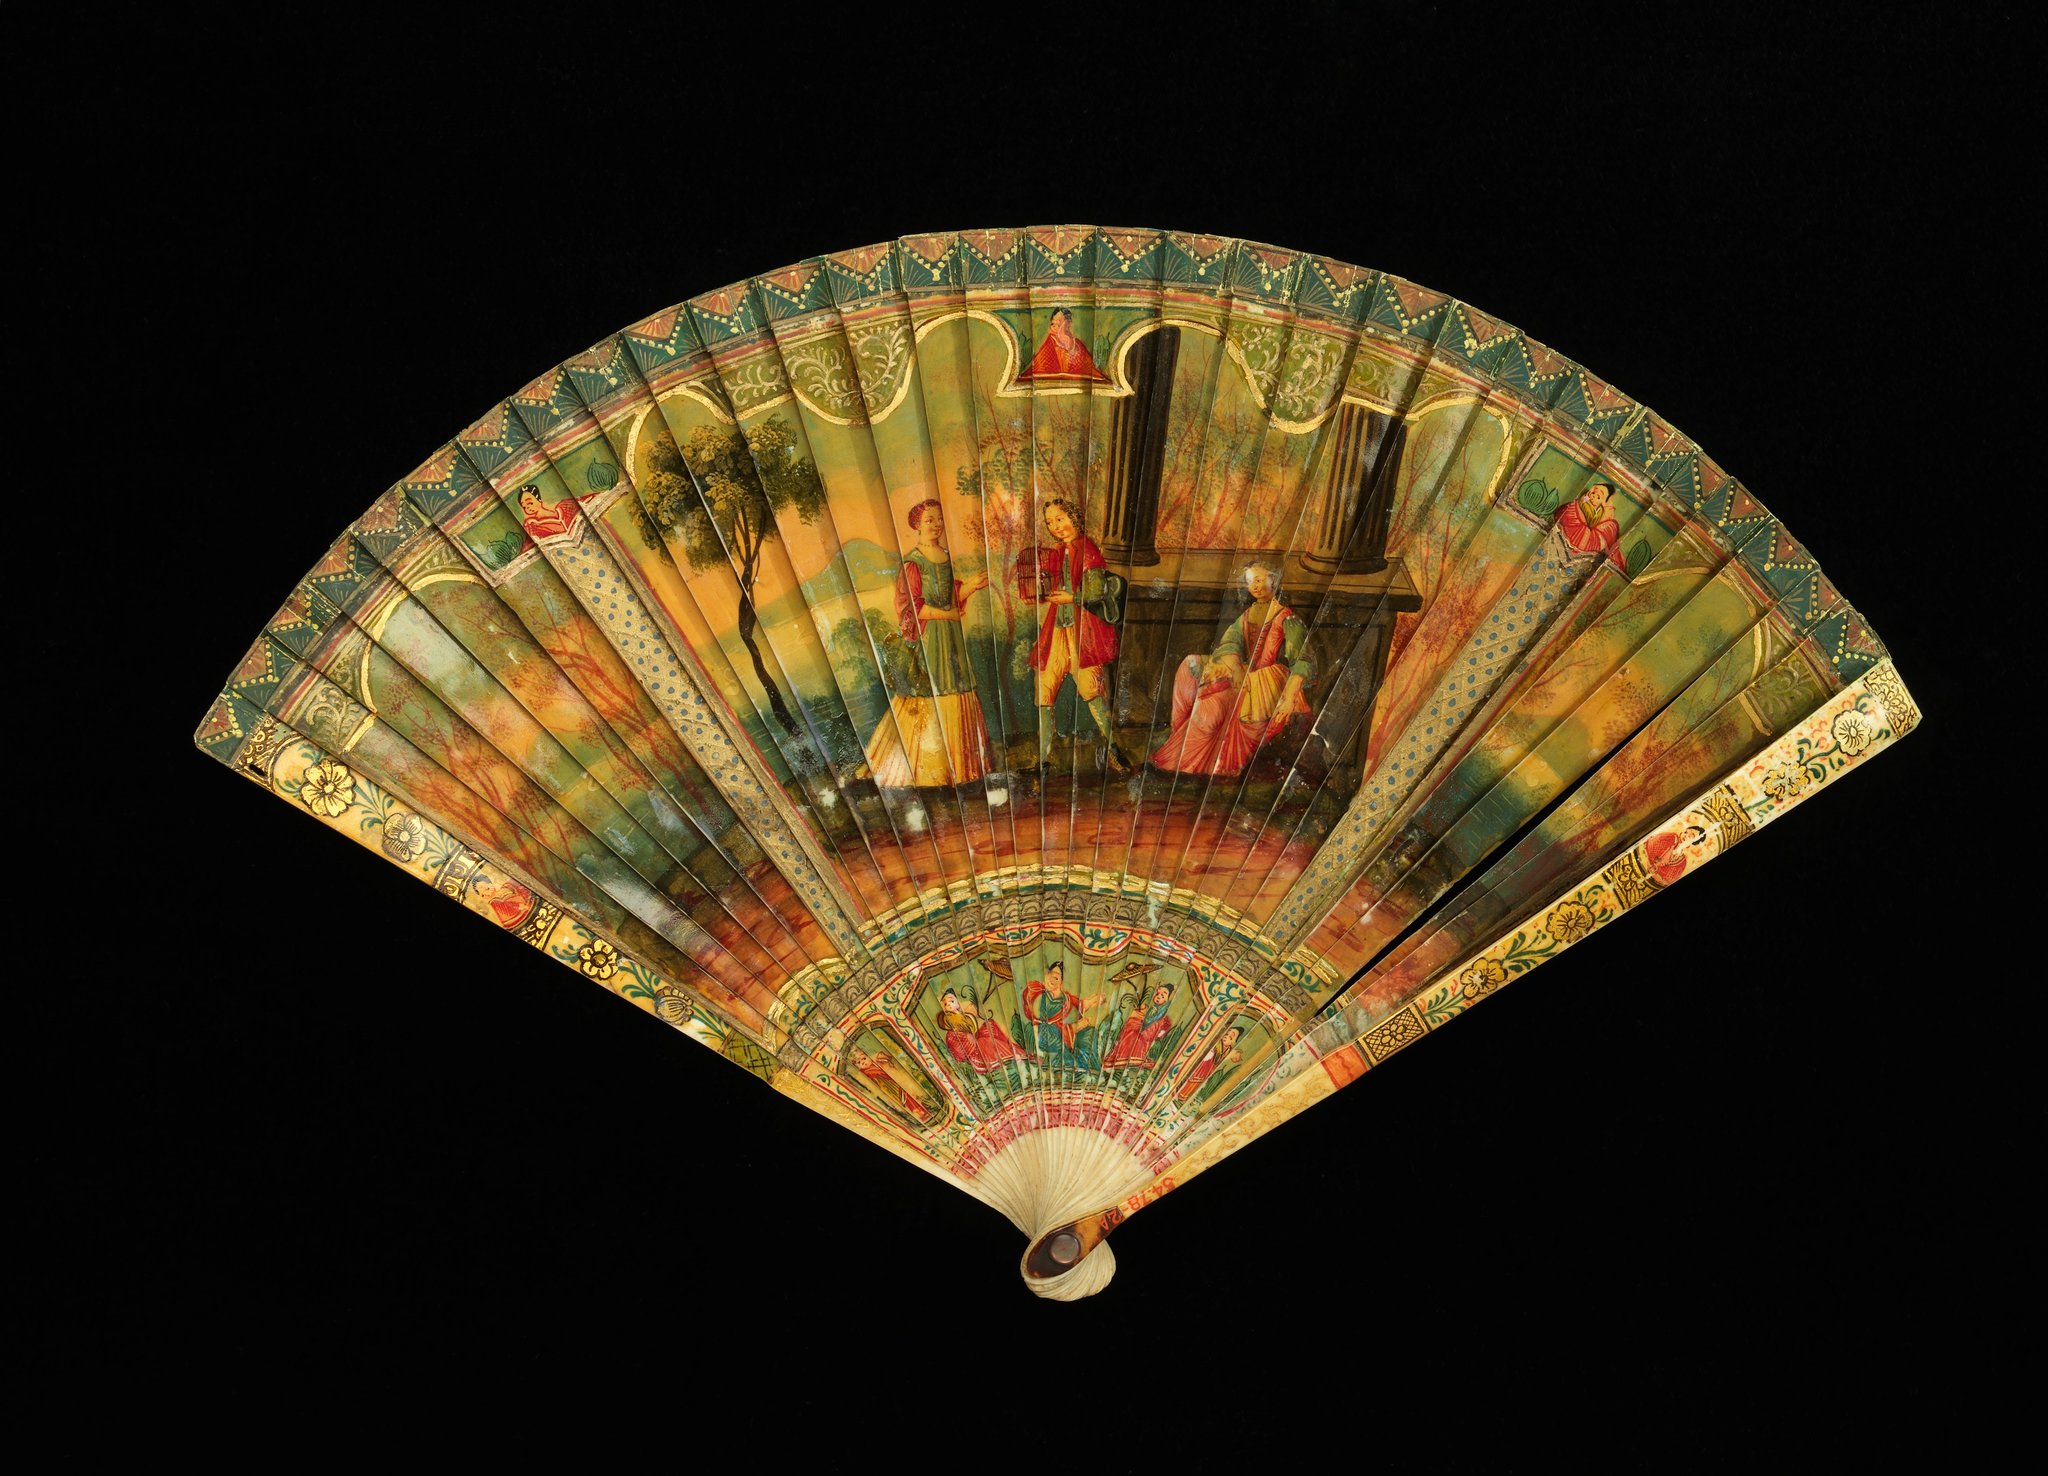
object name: brisé fan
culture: french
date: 1701-1725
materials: ivory, oil, paper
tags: men,women